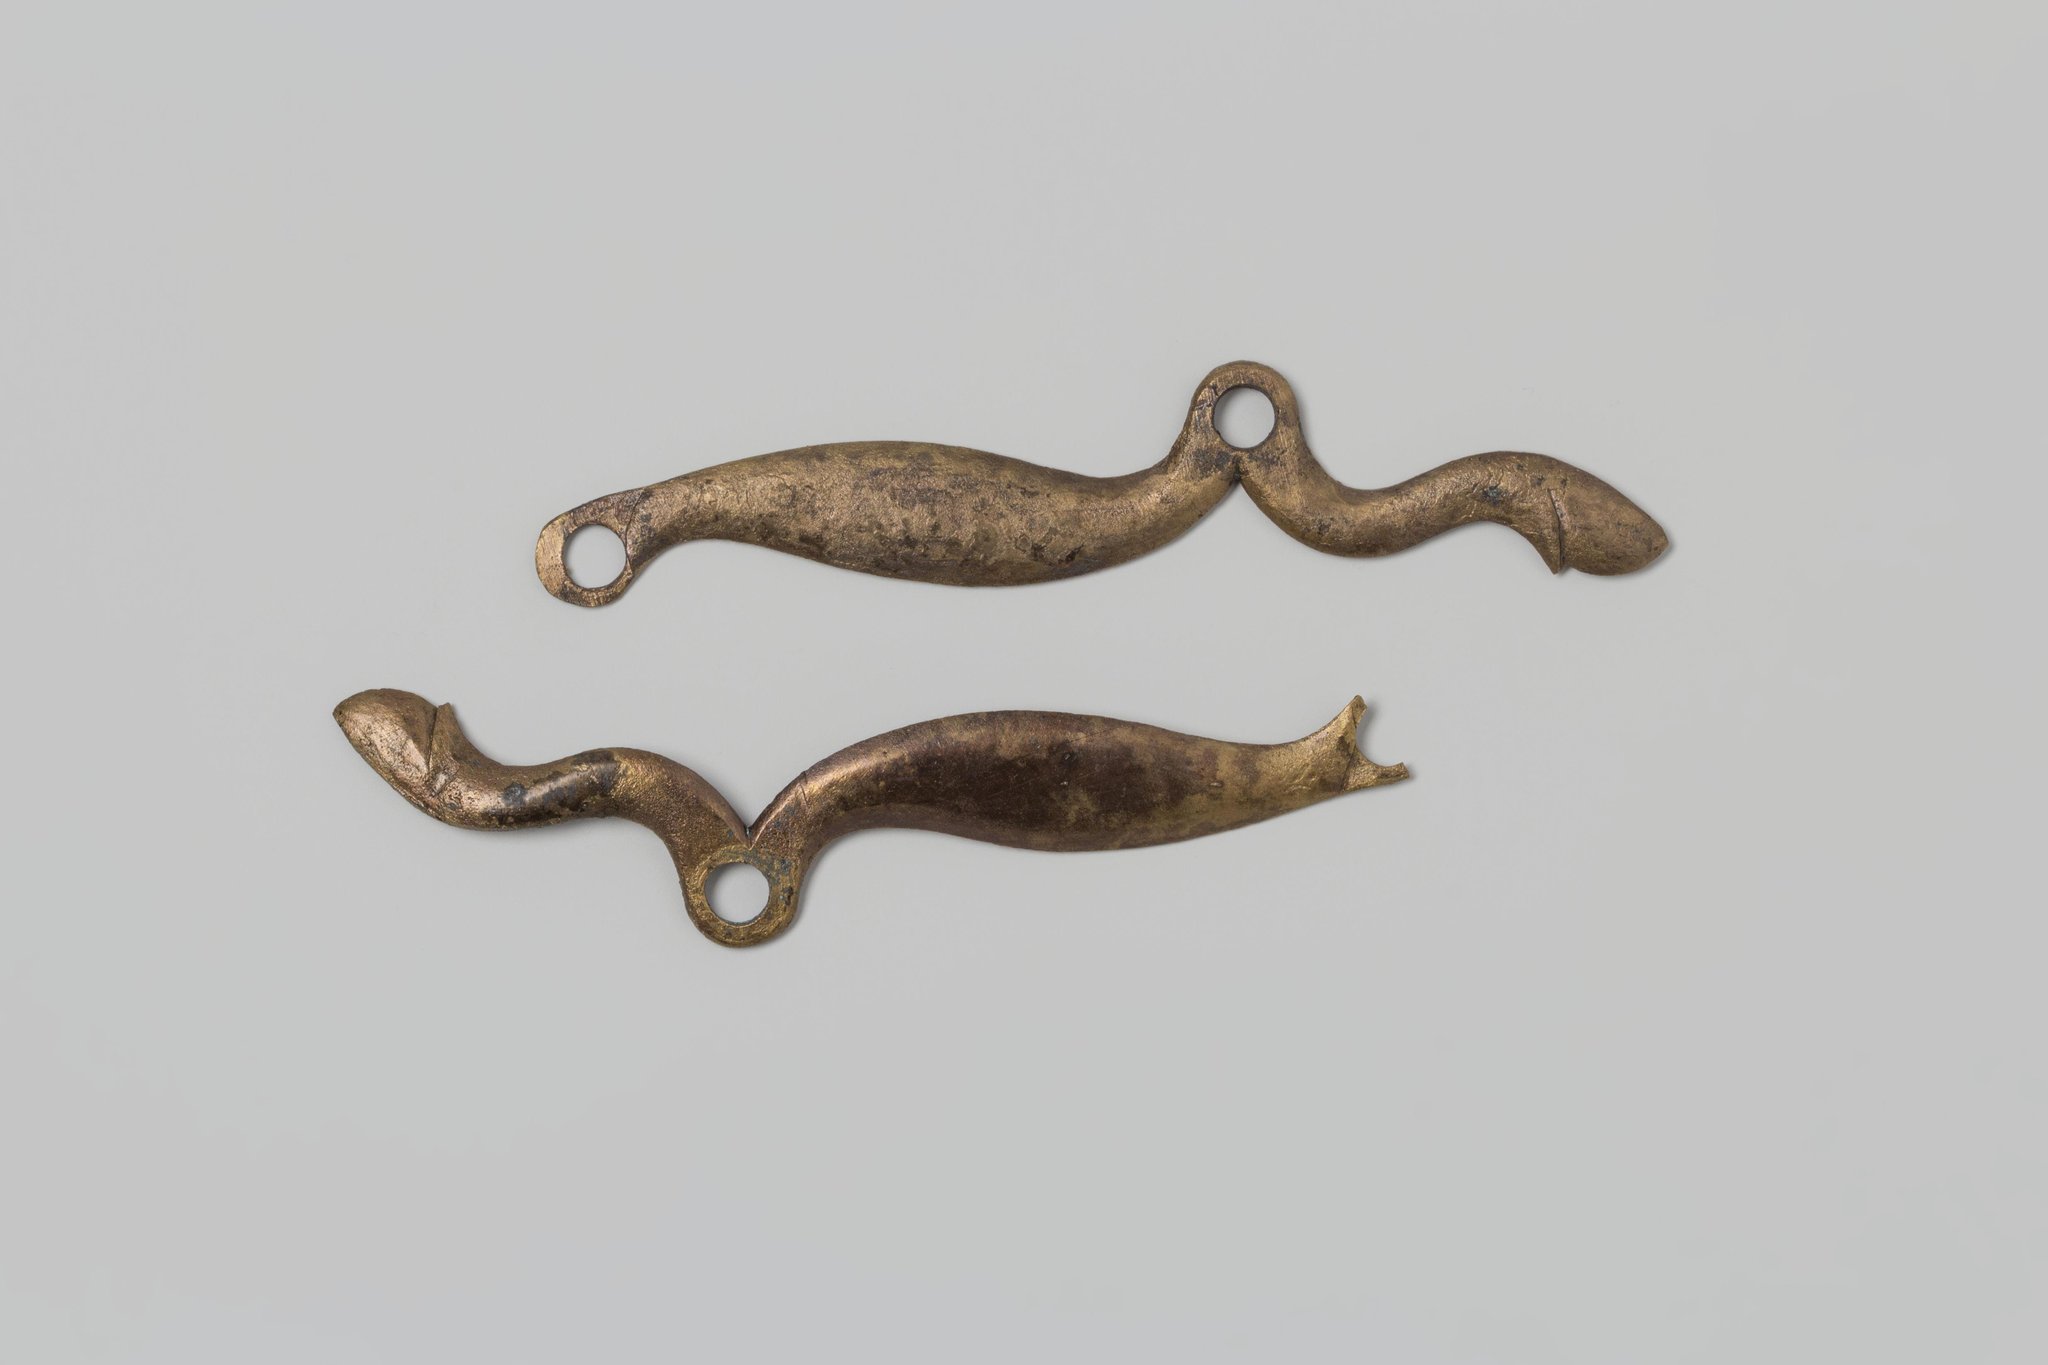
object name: pistol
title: Fragment zijplaat van een pistool uit het wrak van de Oost-Indiëvaarder Hollandia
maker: Anonymous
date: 1700-1743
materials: copper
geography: netherlands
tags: verenigde oostindische compagnie, hollandia (schip), annet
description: Pistol, side plate; central eye with 2 curved wings, one end with a circular eye, plain slightly convex surface.